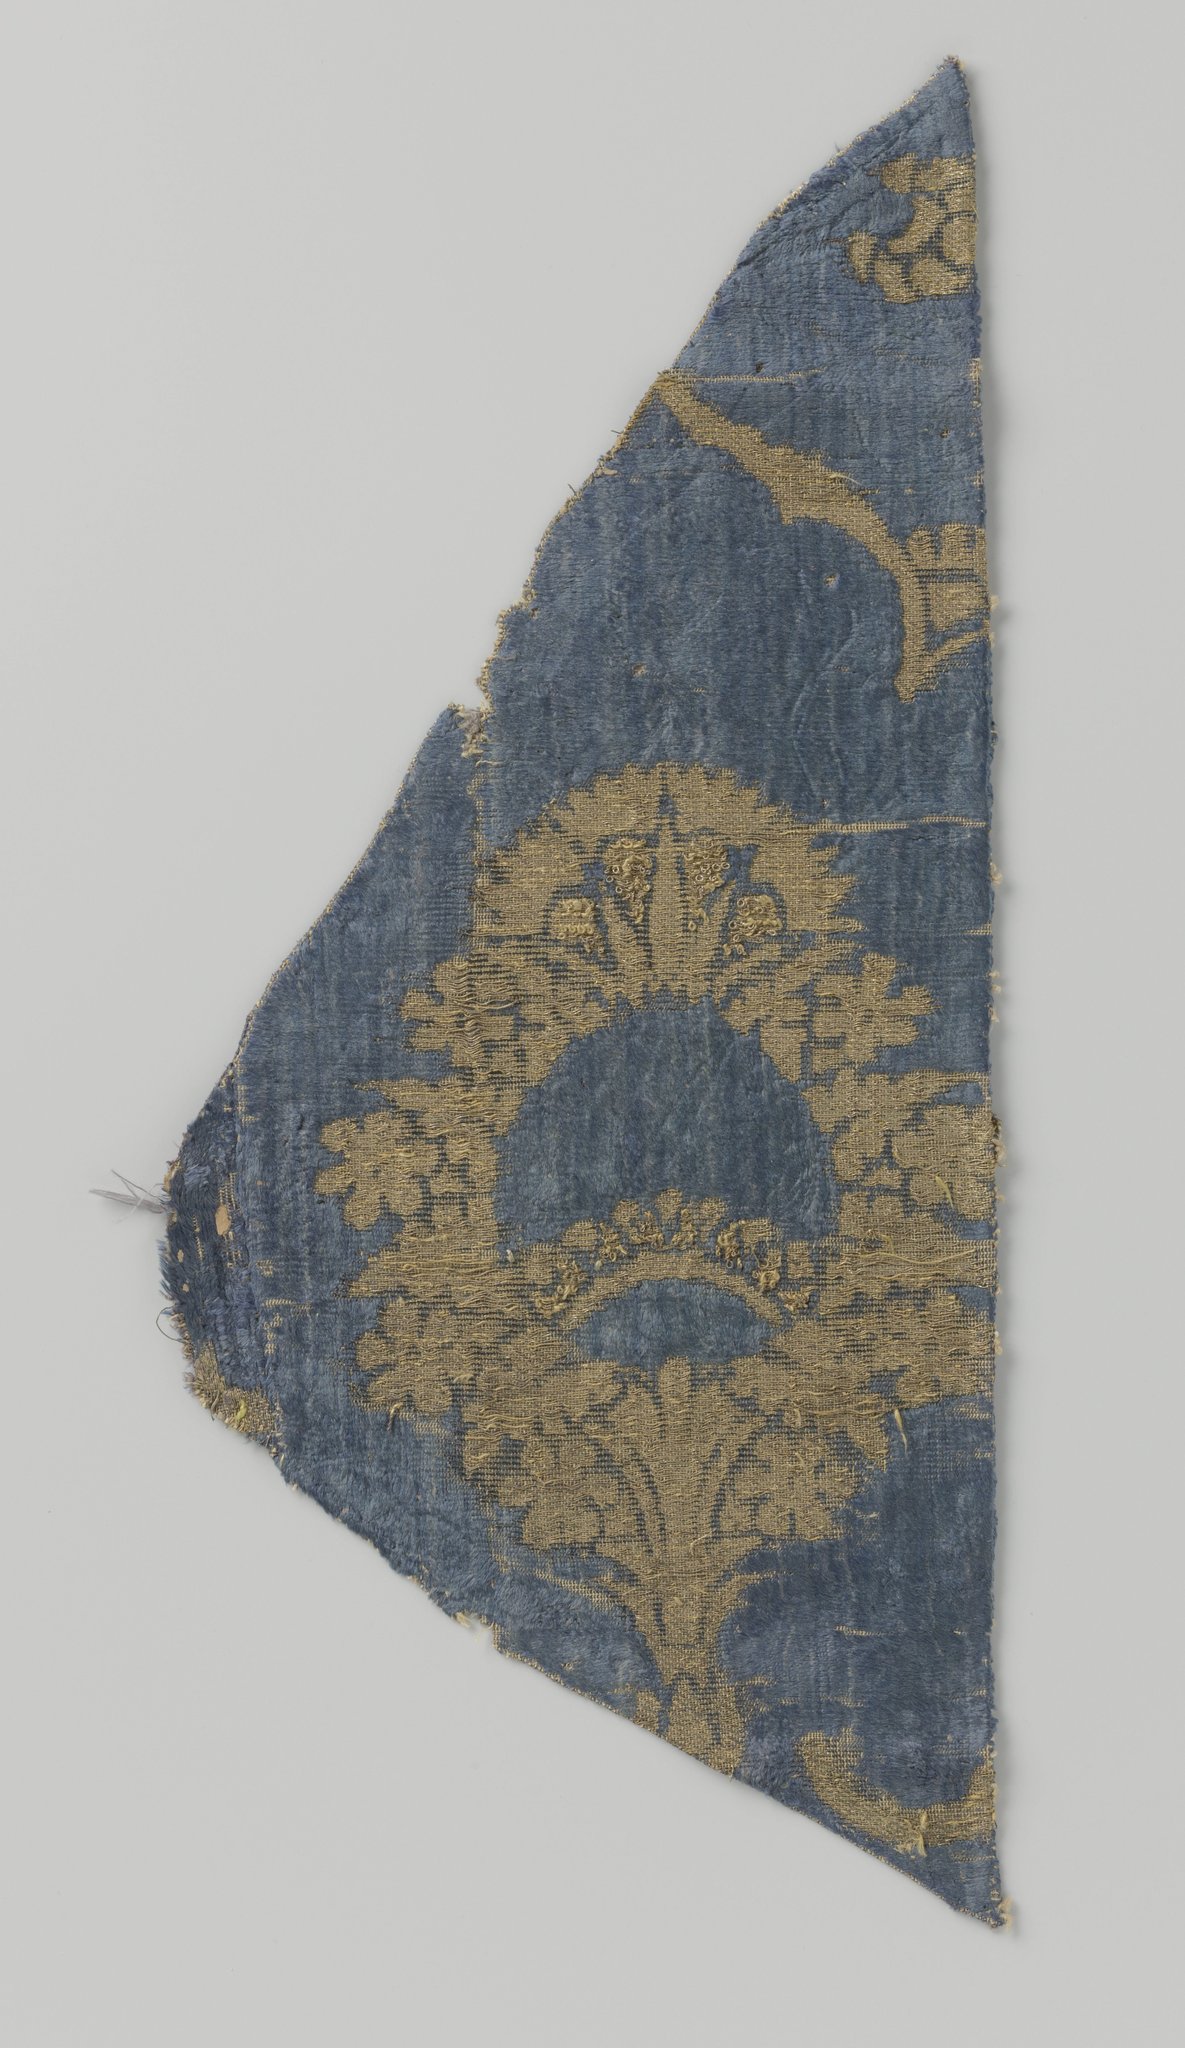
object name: brokaatfluweel, fluweelbrokaat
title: Fragment blauw fluweelbrokaat met granaatappelmotief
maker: Anonymous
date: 1470-1480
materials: gold thread, silk, velvet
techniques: brocade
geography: italy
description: Fragment zijden fluweelbrokaat met op blauwe grond patroon van gouden door bloemen en bladeren omgeven granaatappel in gelobde contour. Zie ook A en C.